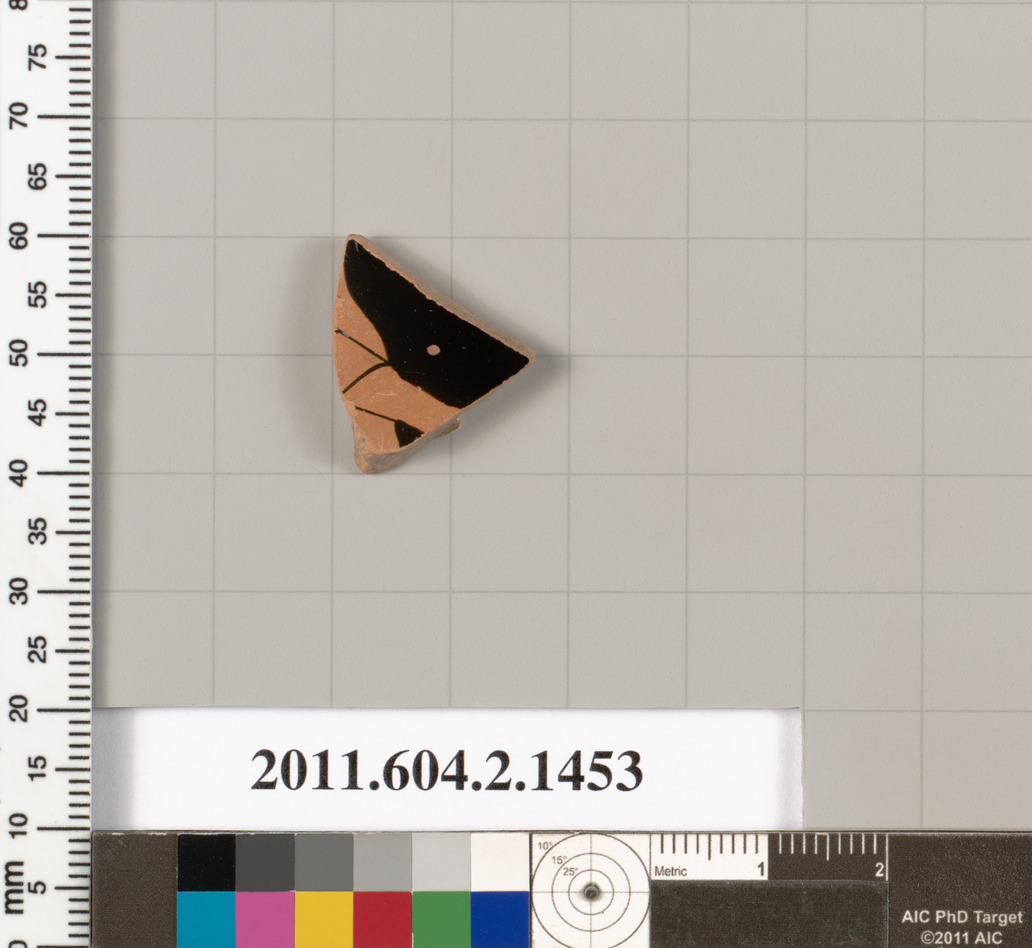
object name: skyphos fragment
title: Terracotta fragment of a skyphos (deep drinking cup)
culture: greek, attic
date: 475-451 BCE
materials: terracotta